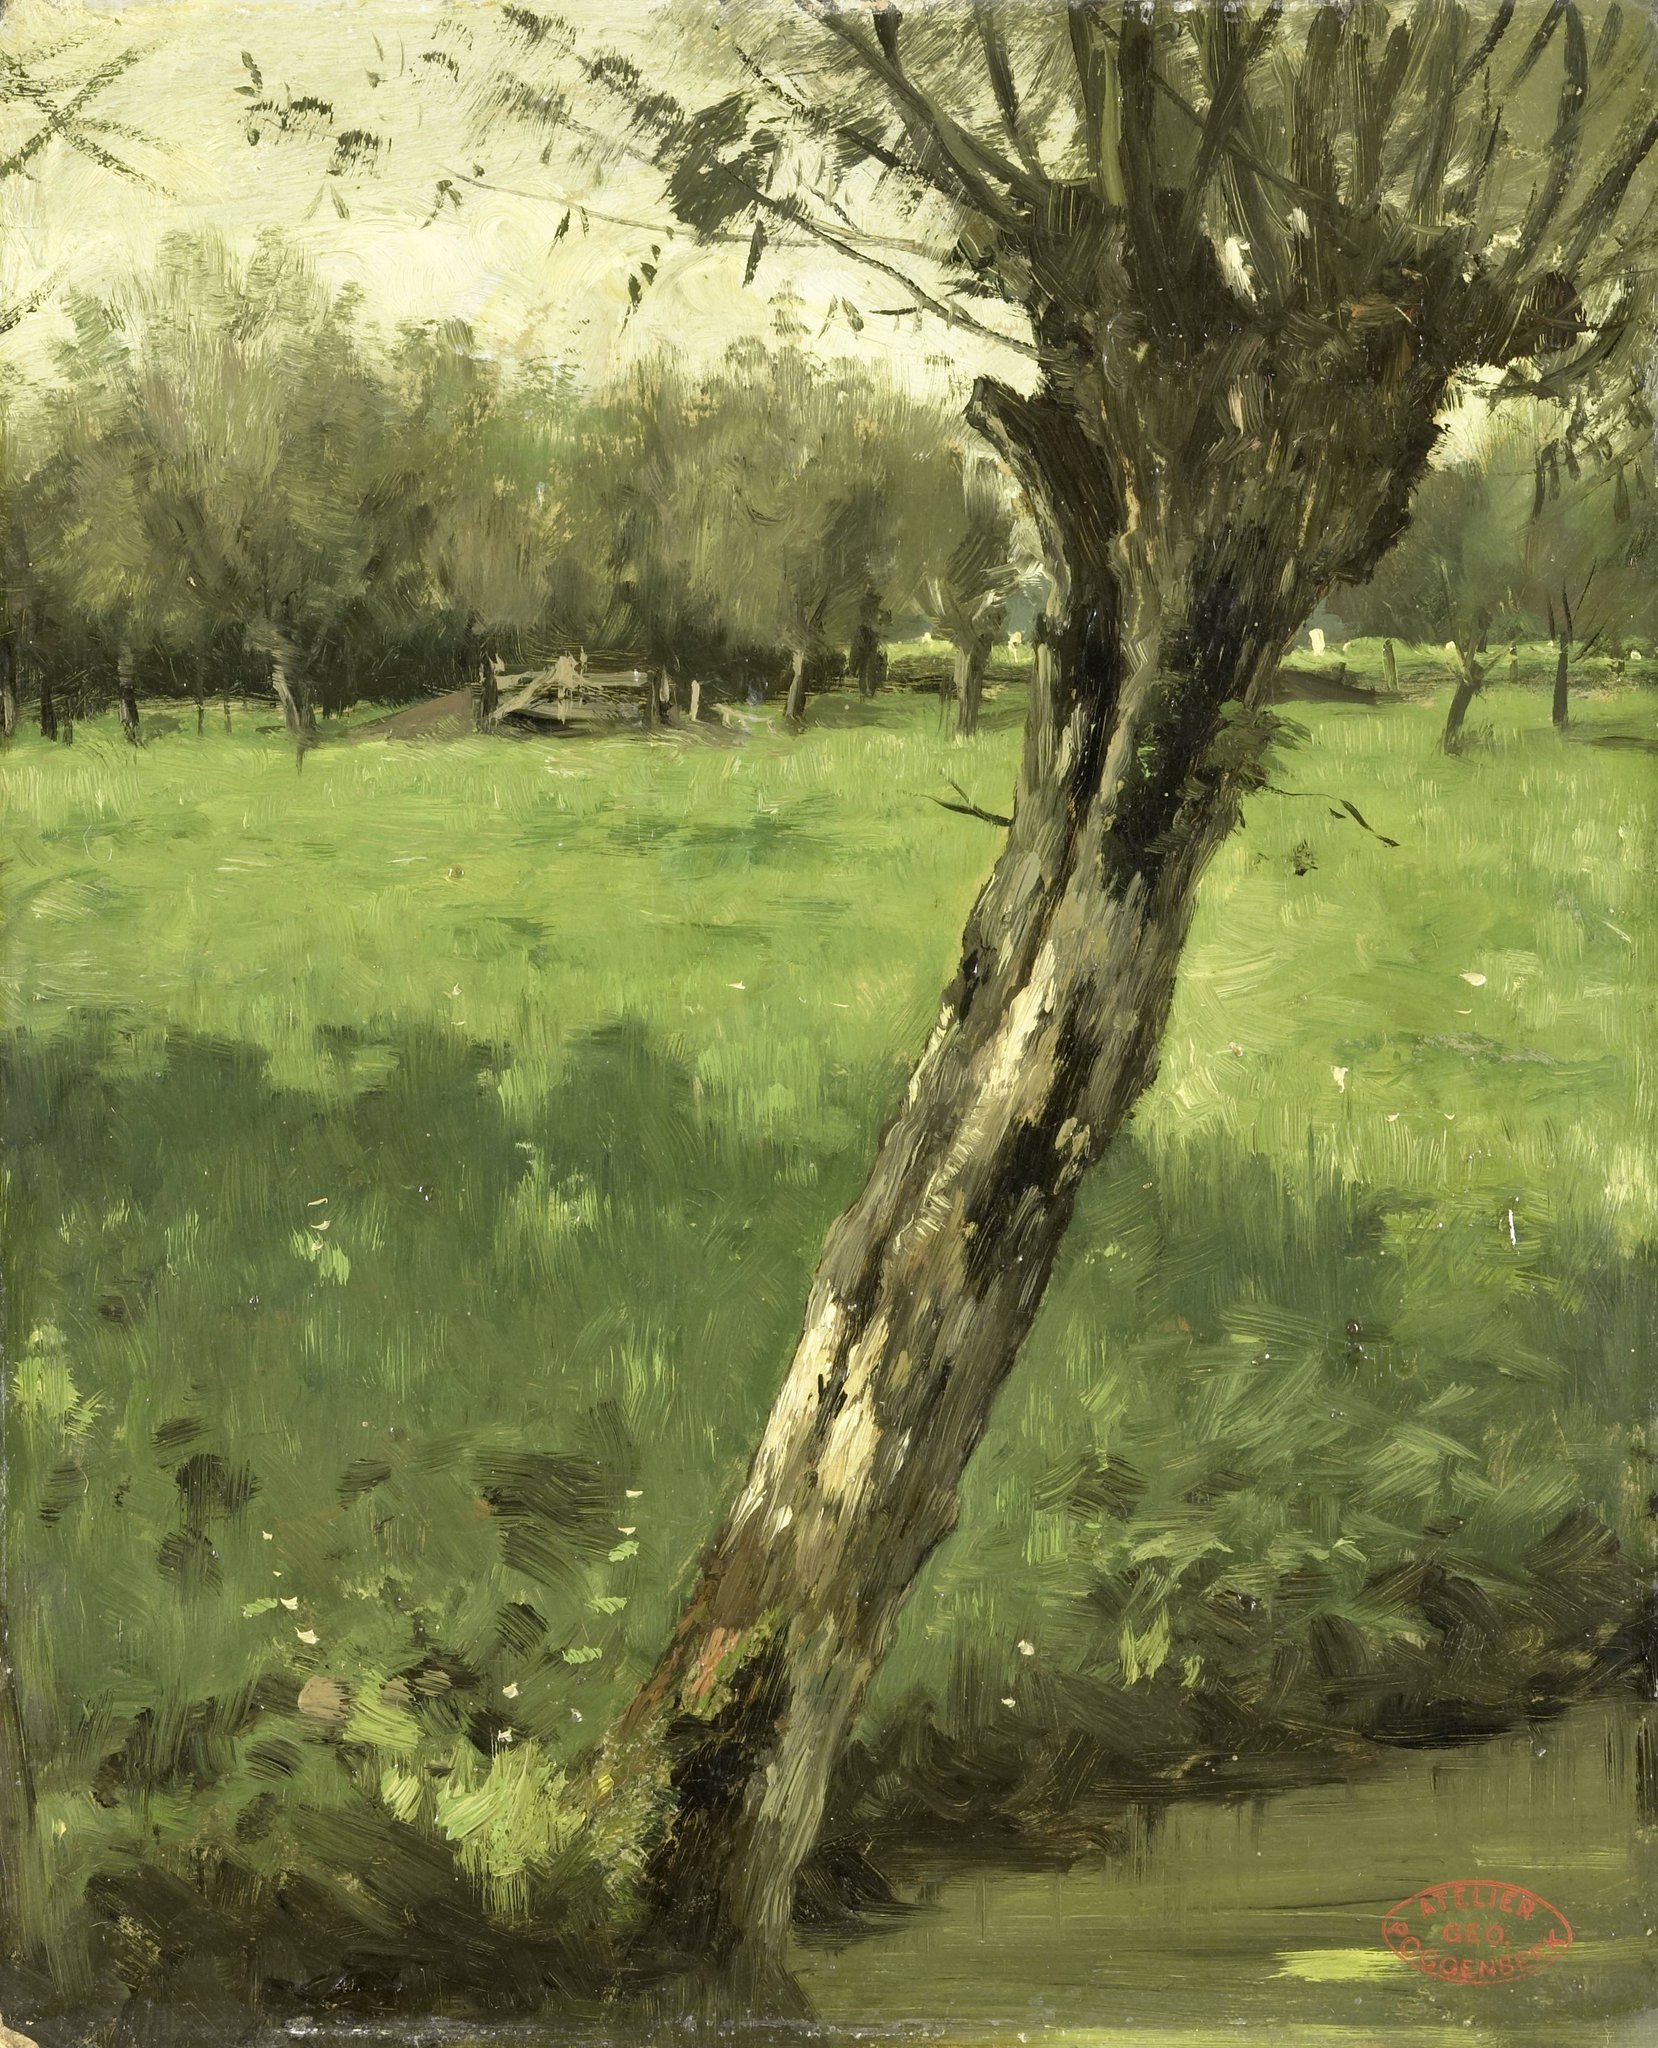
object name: painting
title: The Willow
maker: geo poggenbeek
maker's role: draughtsman, painter, print maker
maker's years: 1853-1903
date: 1873-1903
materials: cardboard, oil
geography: netherlands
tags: meadow, pasture, trees: willow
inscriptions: workshop stamp: ‘Atelier Geo. Poggenbeek’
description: Schuinstaande knotwilg aan de slootrand van een weide.